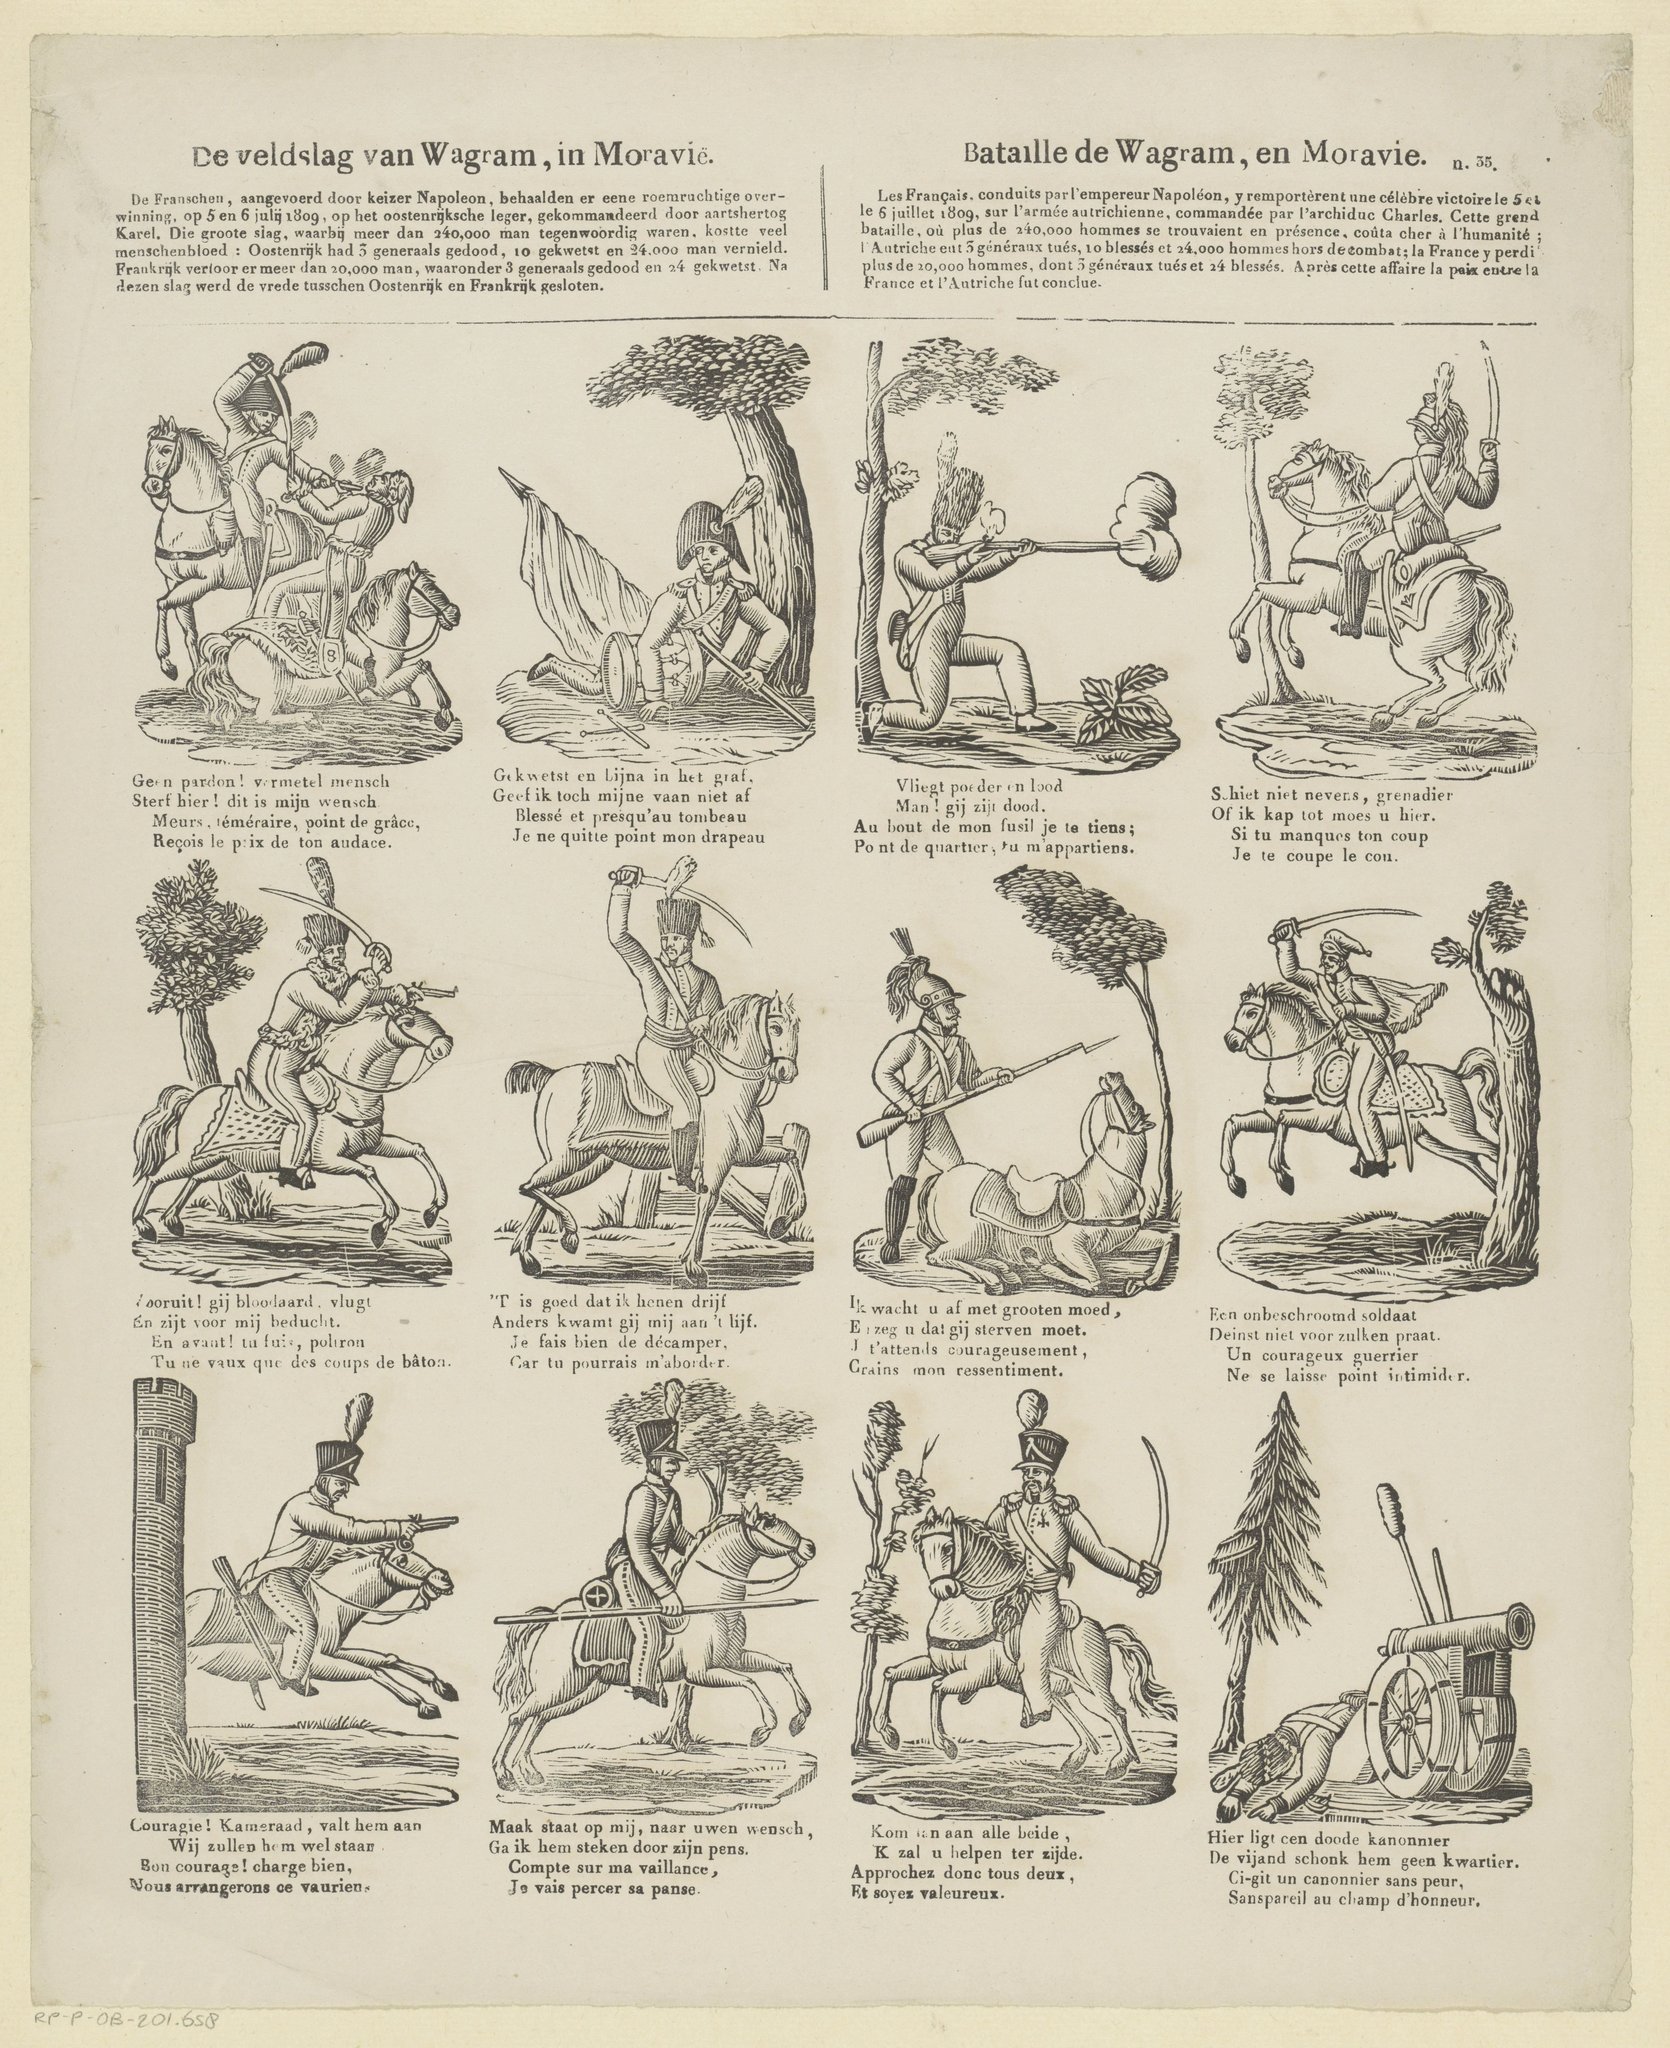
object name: popular print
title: De veldslag van Wagram, in Maravië / Bataille de Wagram, en Marovie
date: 1800-1833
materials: paper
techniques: letterpress printing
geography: turnhout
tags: warfare; military affairs (+ cavalry, horsemen), the soldier; the soldier's life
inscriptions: collector's mark: Lugt 2760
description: Blad met 12 voorstellingen van vechtende soldaten tijdens de Slag van Wagram. Onder elke afbeelding een tweeregelig vers in het Nederlands of in het Frans, een zesregelig bovenschrift in het Nederlands en in het Frans in twee kolommen. Genummerd rechtsboven: n. 35.